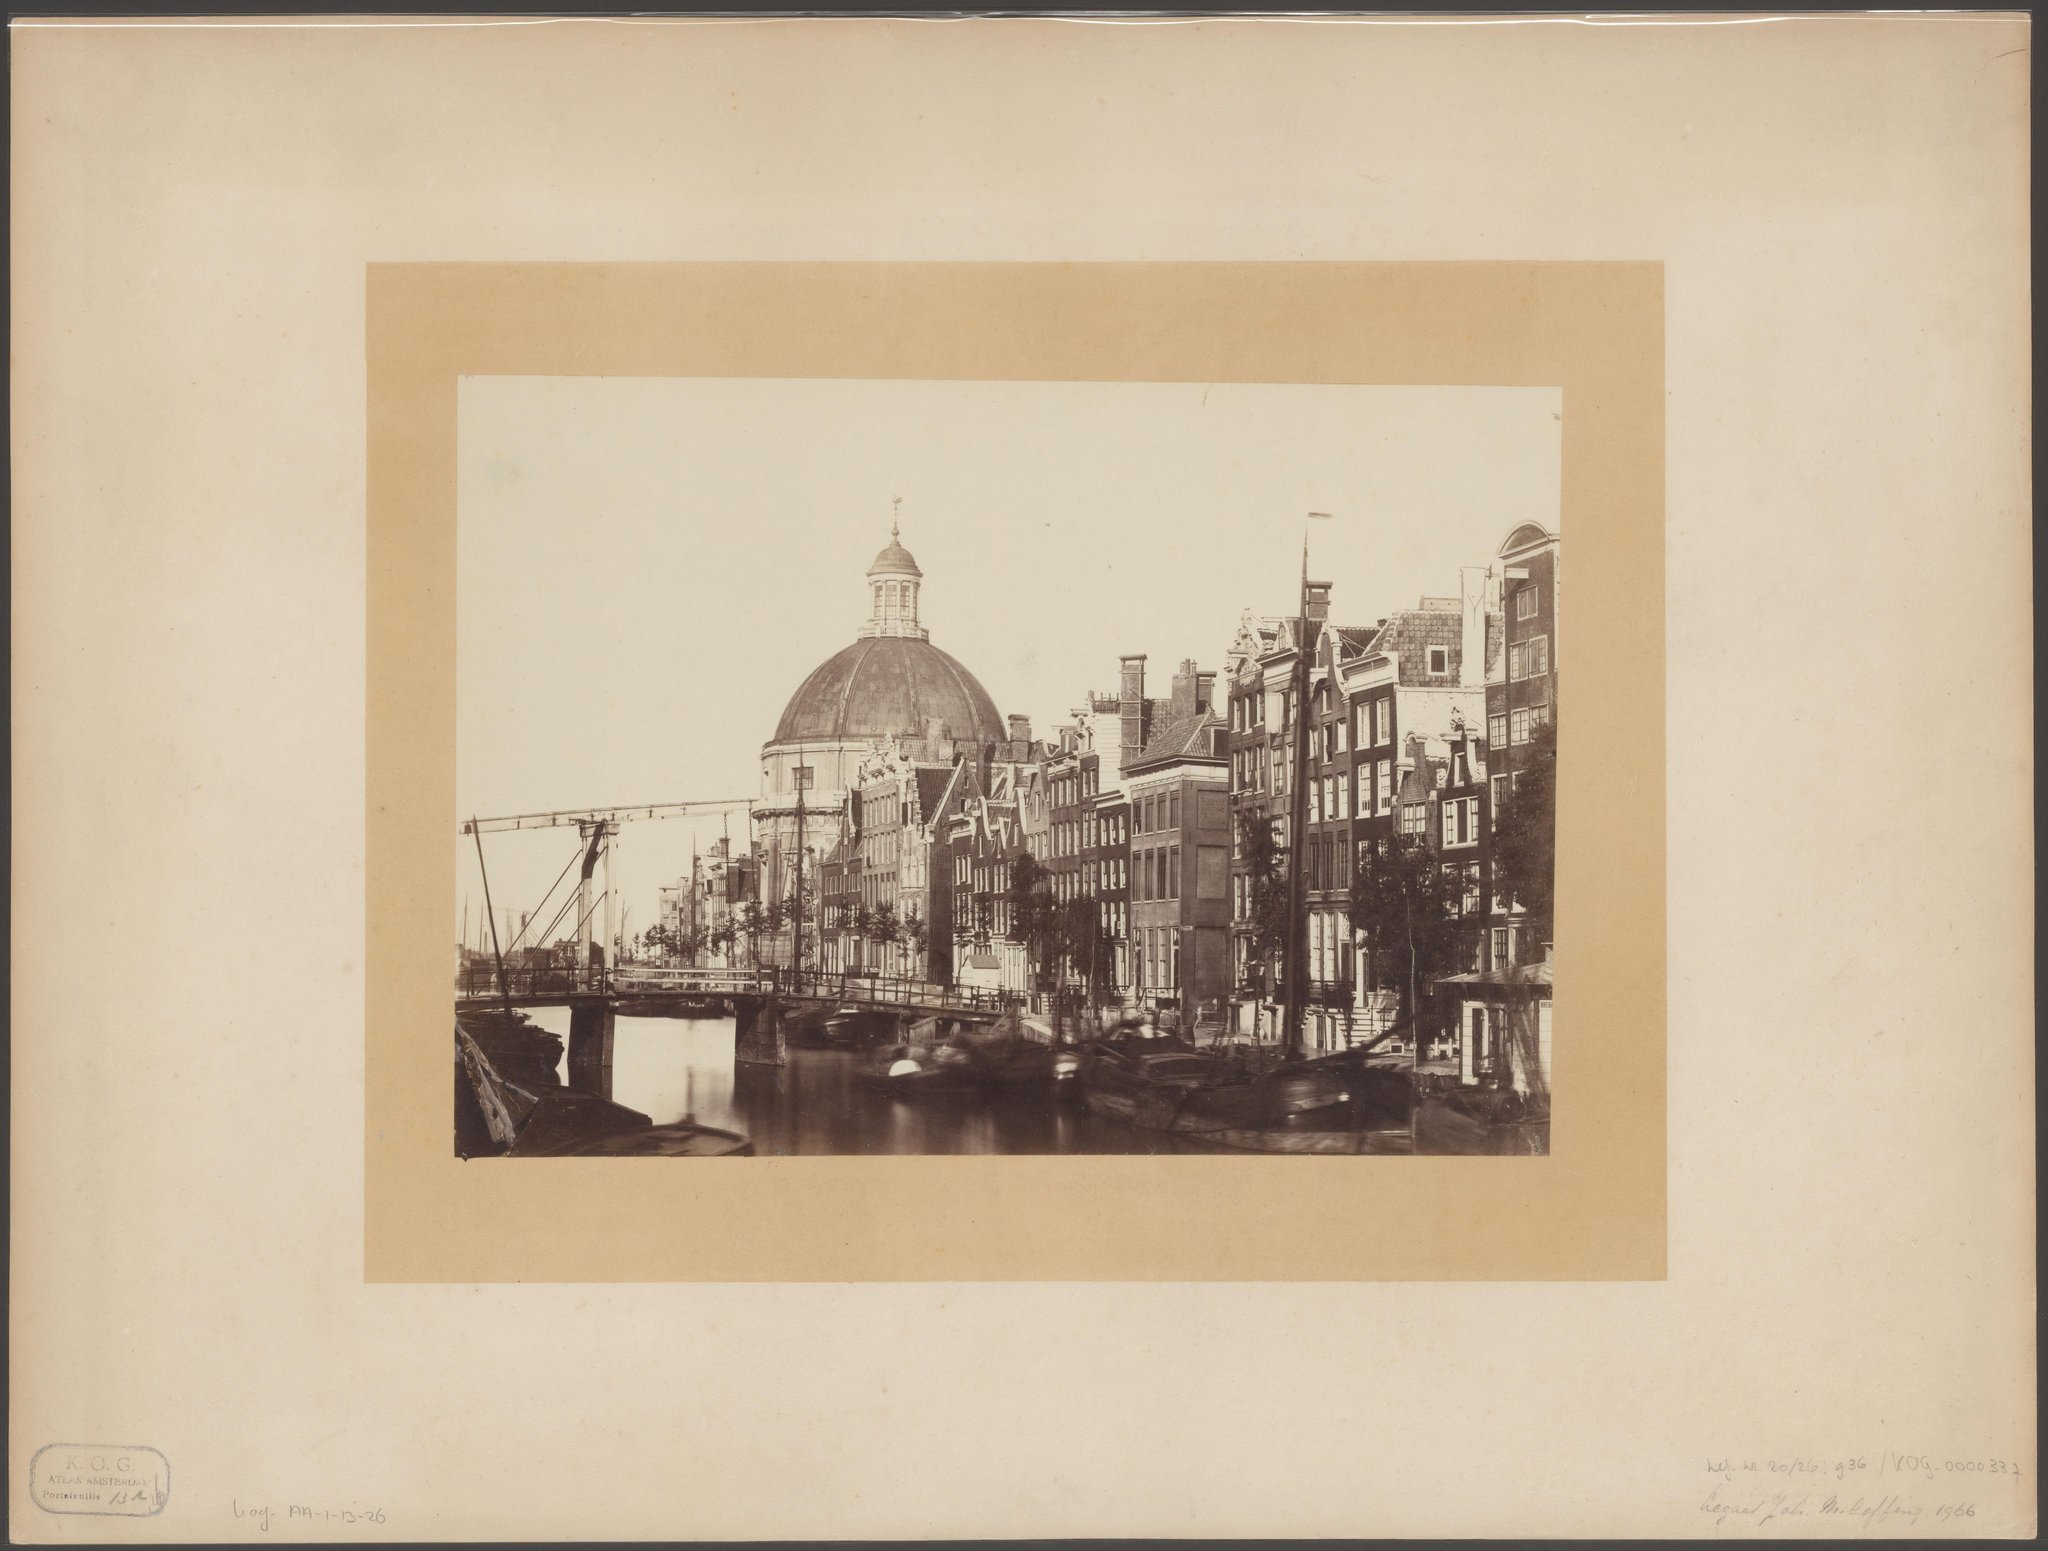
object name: photograph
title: Gezicht op de Ronde Lutherse Kerk aan het Singel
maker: Anonymous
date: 1850-1915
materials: cardboard, paper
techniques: albumen print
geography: amsterdam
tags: city-view in general; 'veduta', canal, church (exterior), bridge in city across river, canal, etc., boat propelled by man or animal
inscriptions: collector's mark: ‘13A,26’ Lugt 1641b, inscription: ‘Legaat Joh. M. Coffeng, 1966’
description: Onderwerpsrubriek binnen de Atlas Amsterdam: Oude Schans, Schoutensteeg, Singel (Korte), Singel.